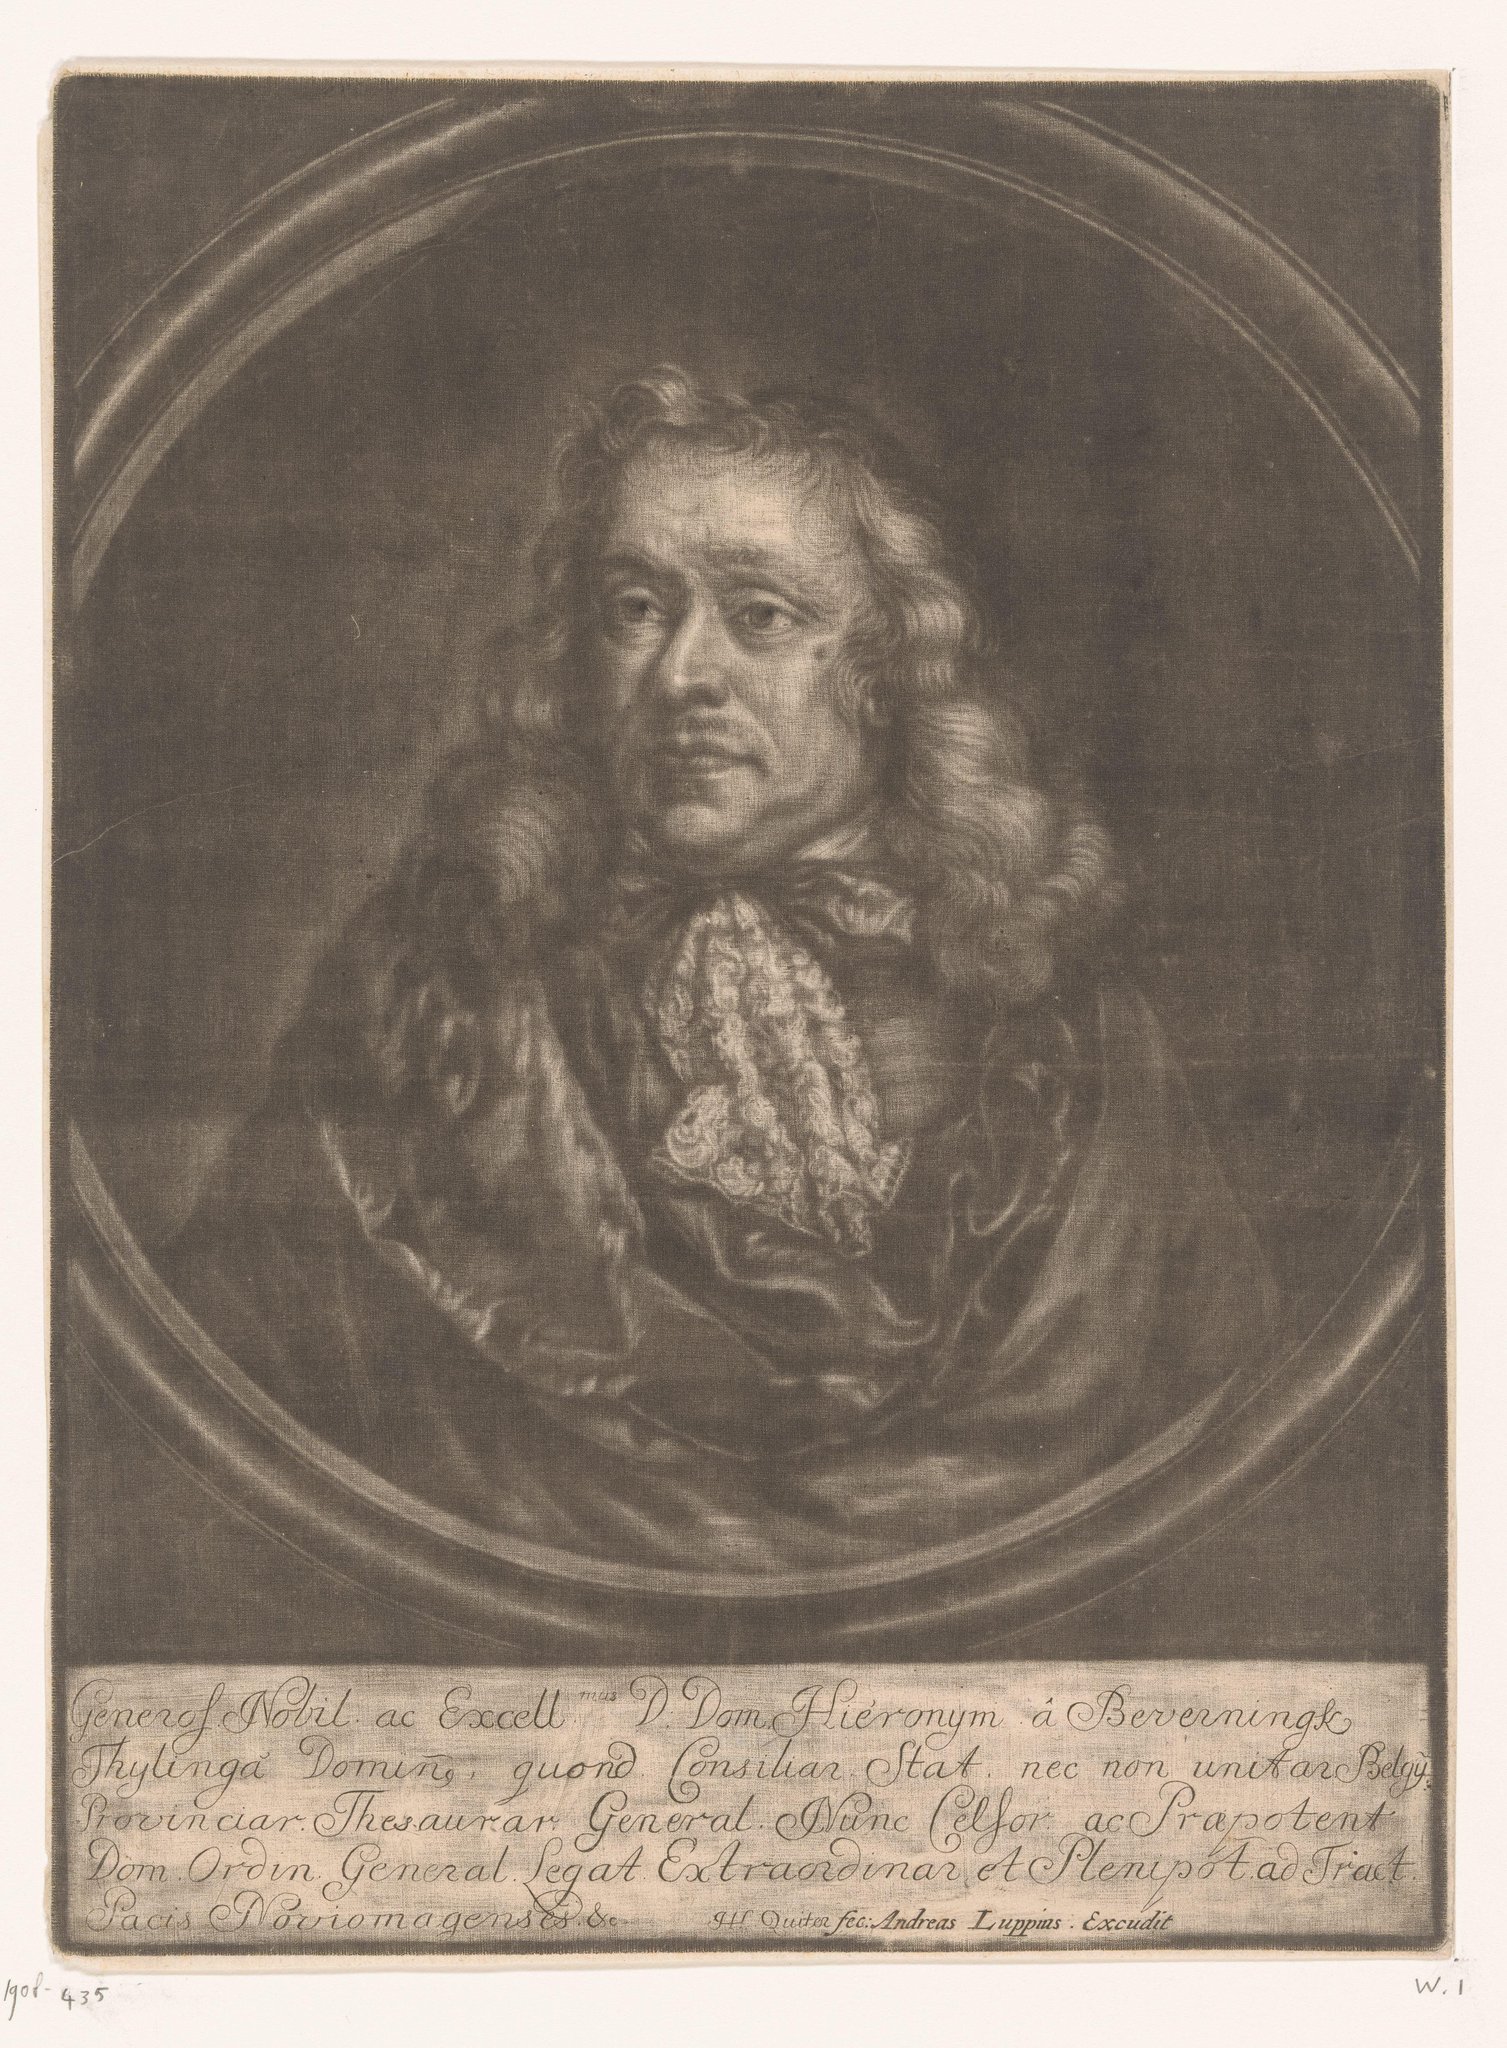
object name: print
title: Portret van Hieronymus van Beverningk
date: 1679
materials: paper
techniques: mezzotint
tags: gouda, leiden, historical persons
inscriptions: collector's mark: Lugt 2228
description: Prent voor het eerst gebruikt in: Quiter, Hermann Hendrik. Icones legatorum (...). Nijmegen: s.n., 1679.